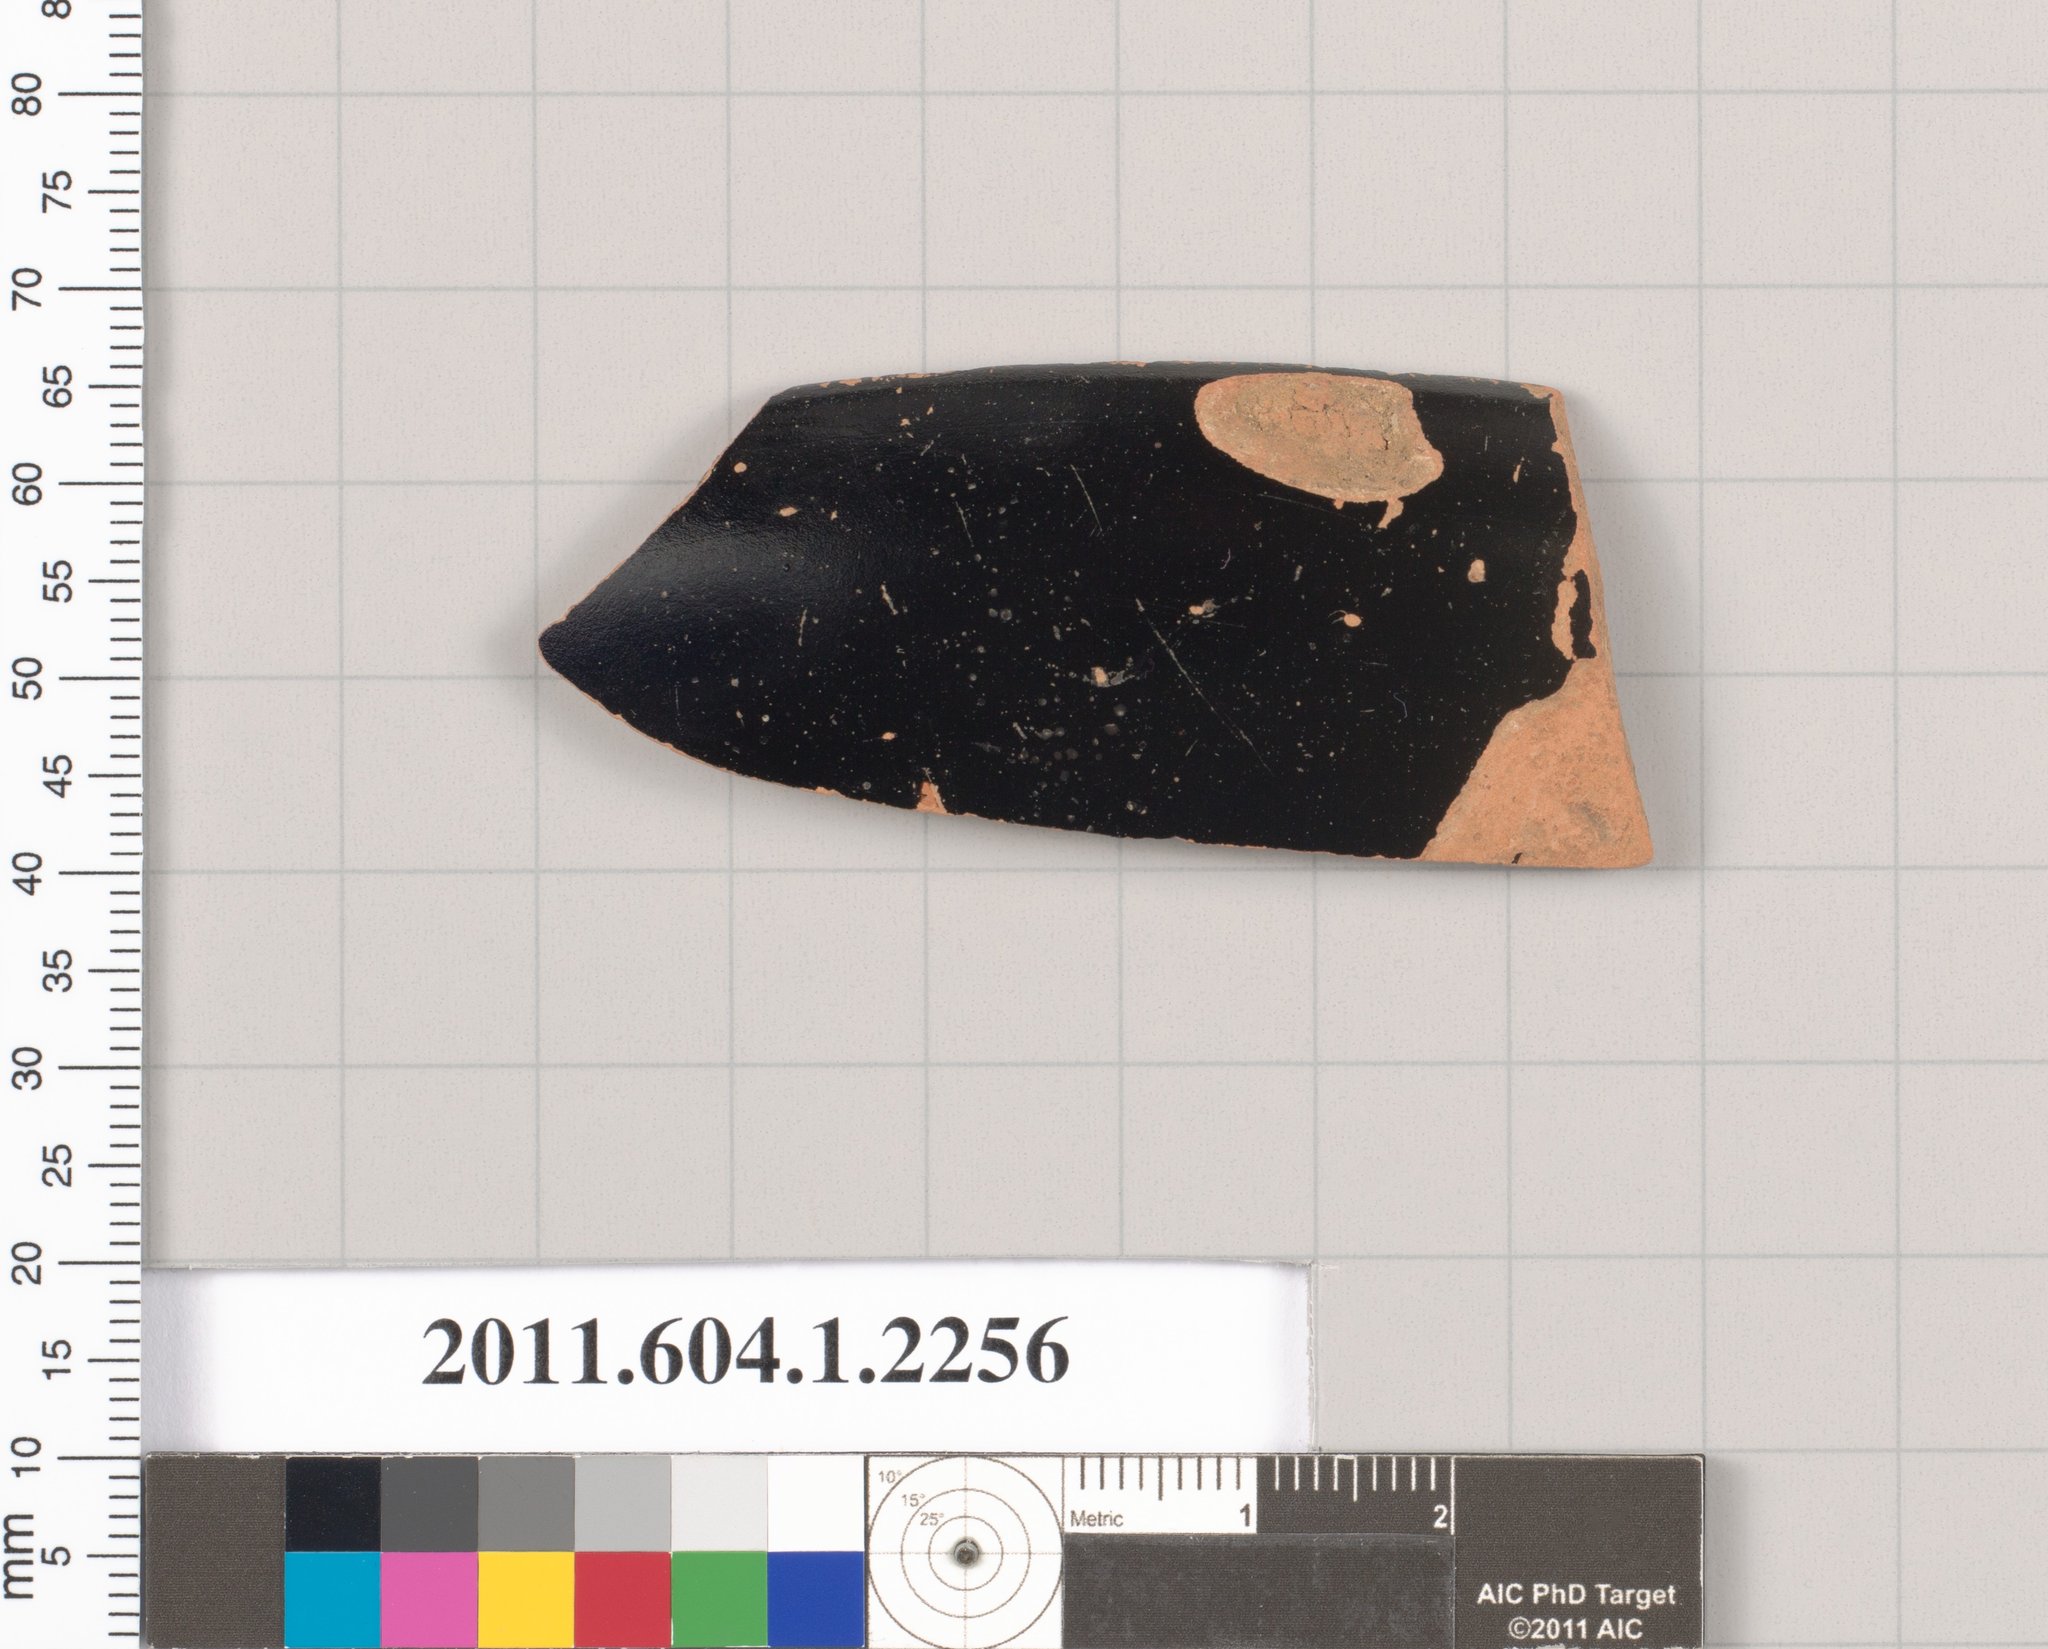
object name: kylix fragment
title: Terracotta rim fragment of a kylix (drinking cup)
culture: greek, attic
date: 467-435 BCE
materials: terracotta